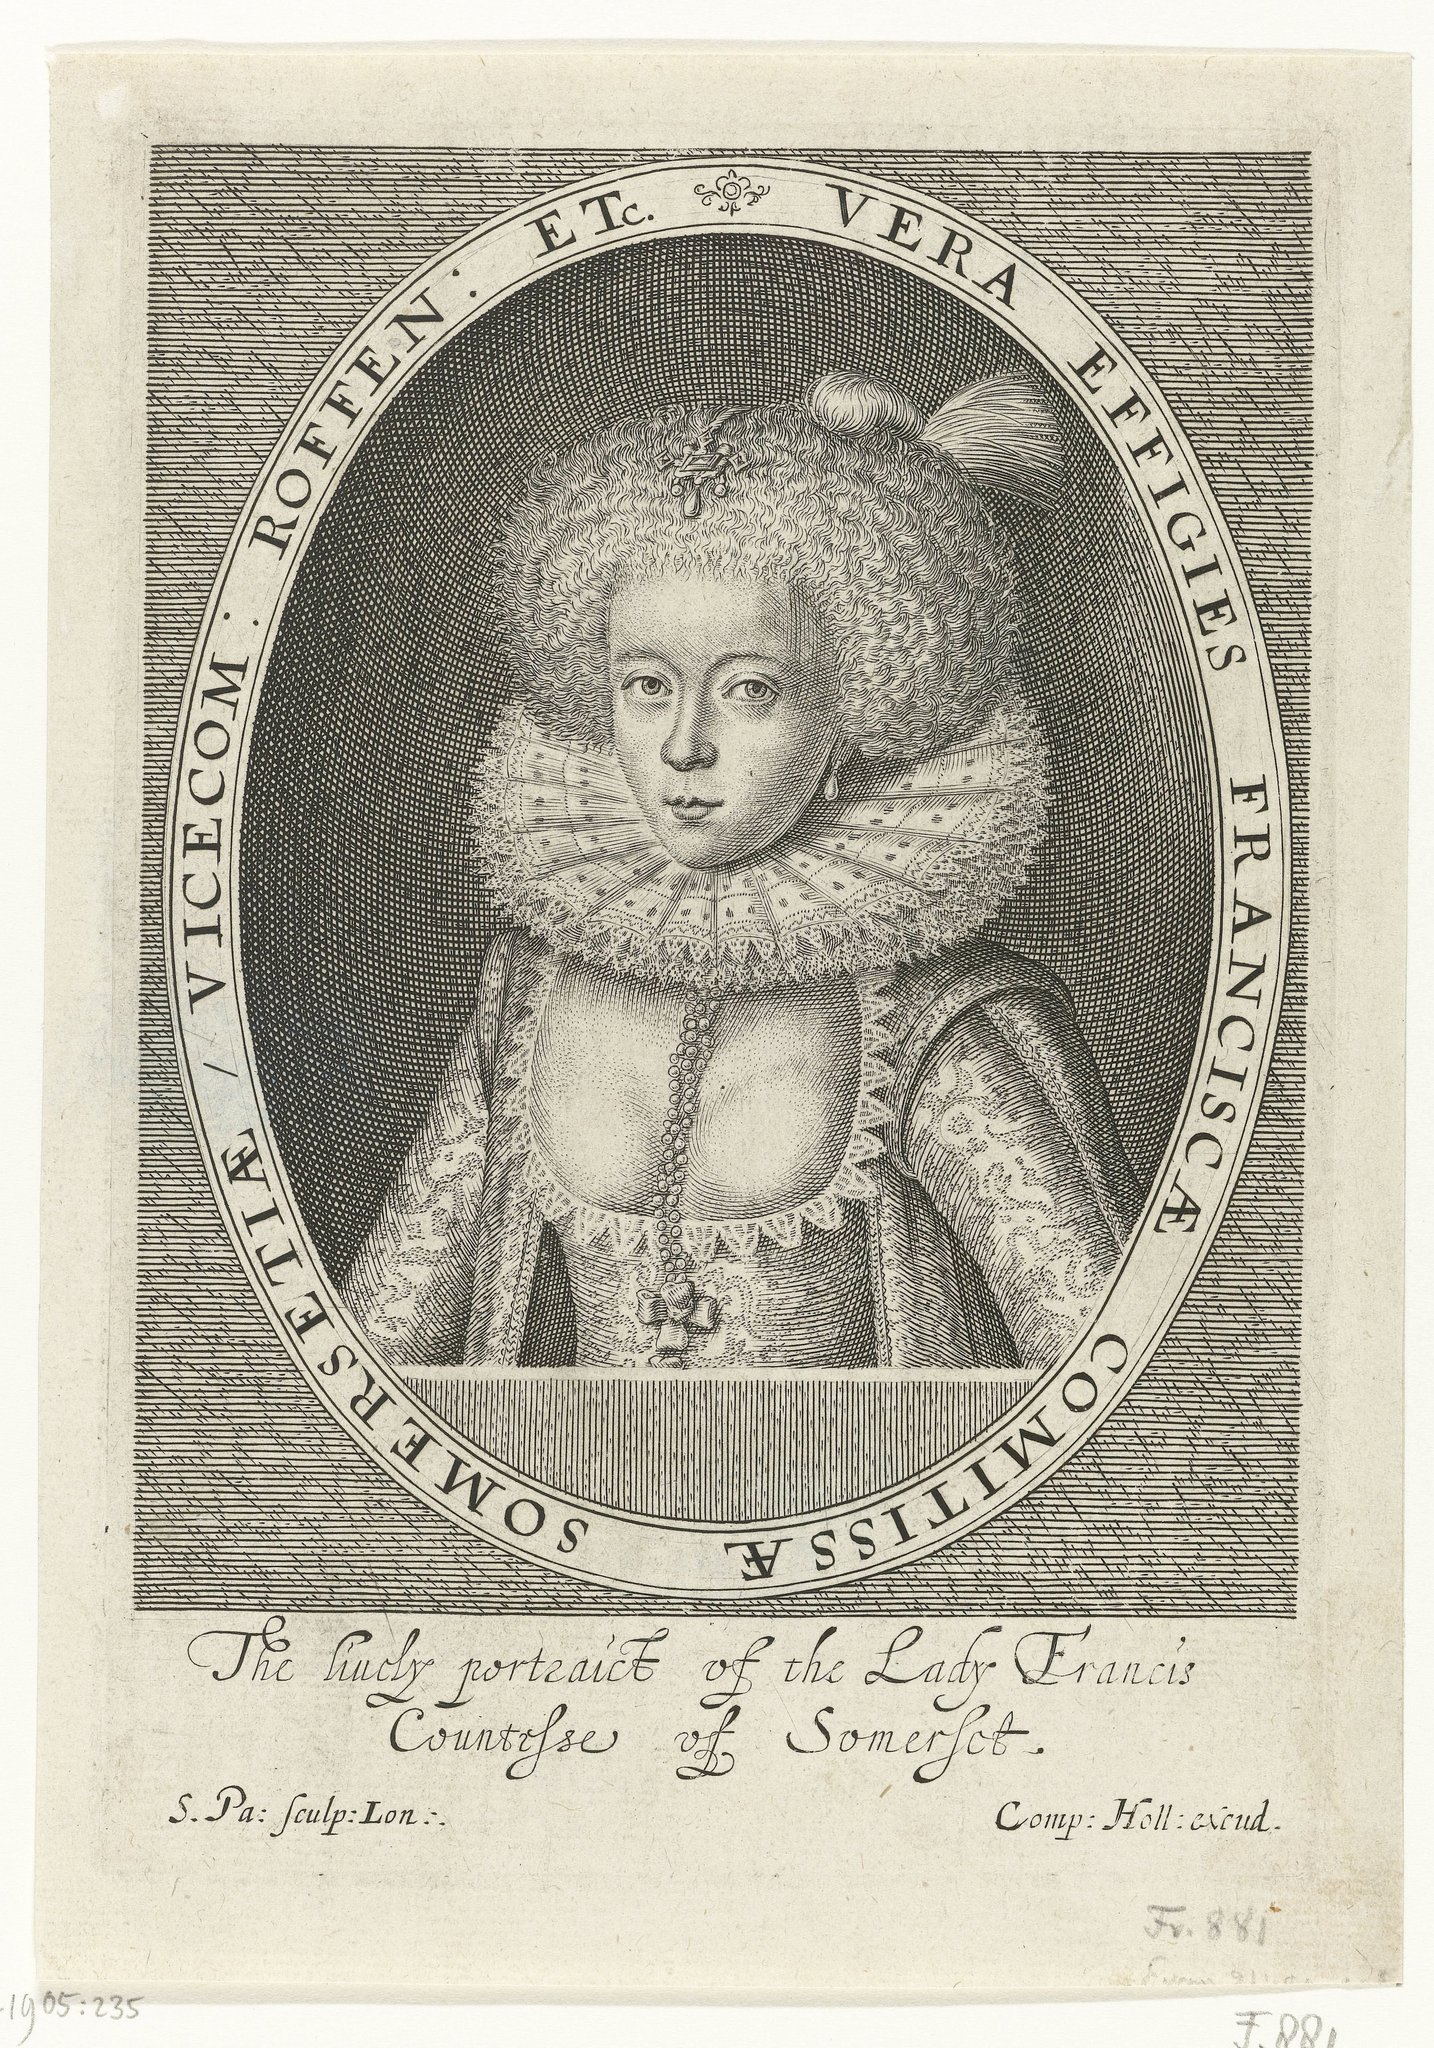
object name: print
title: Portret van Frances Carr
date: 1615-1622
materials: paper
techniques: engraving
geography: london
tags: historical persons - bb - woman, sleeves, 'décolleté', neck-gear ~ clothing (with name) (+ women's clothes), hairdress - aa - ~ women, sleeves (+ women's clothes), necklace (+ women's clothes), clothing for the upper part of the body (with name) (+ women's clothes)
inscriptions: collector's mark: Lugt 2228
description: Kleding: Zeer laag decolleté waarboven brede plooikraag. Kapsel: